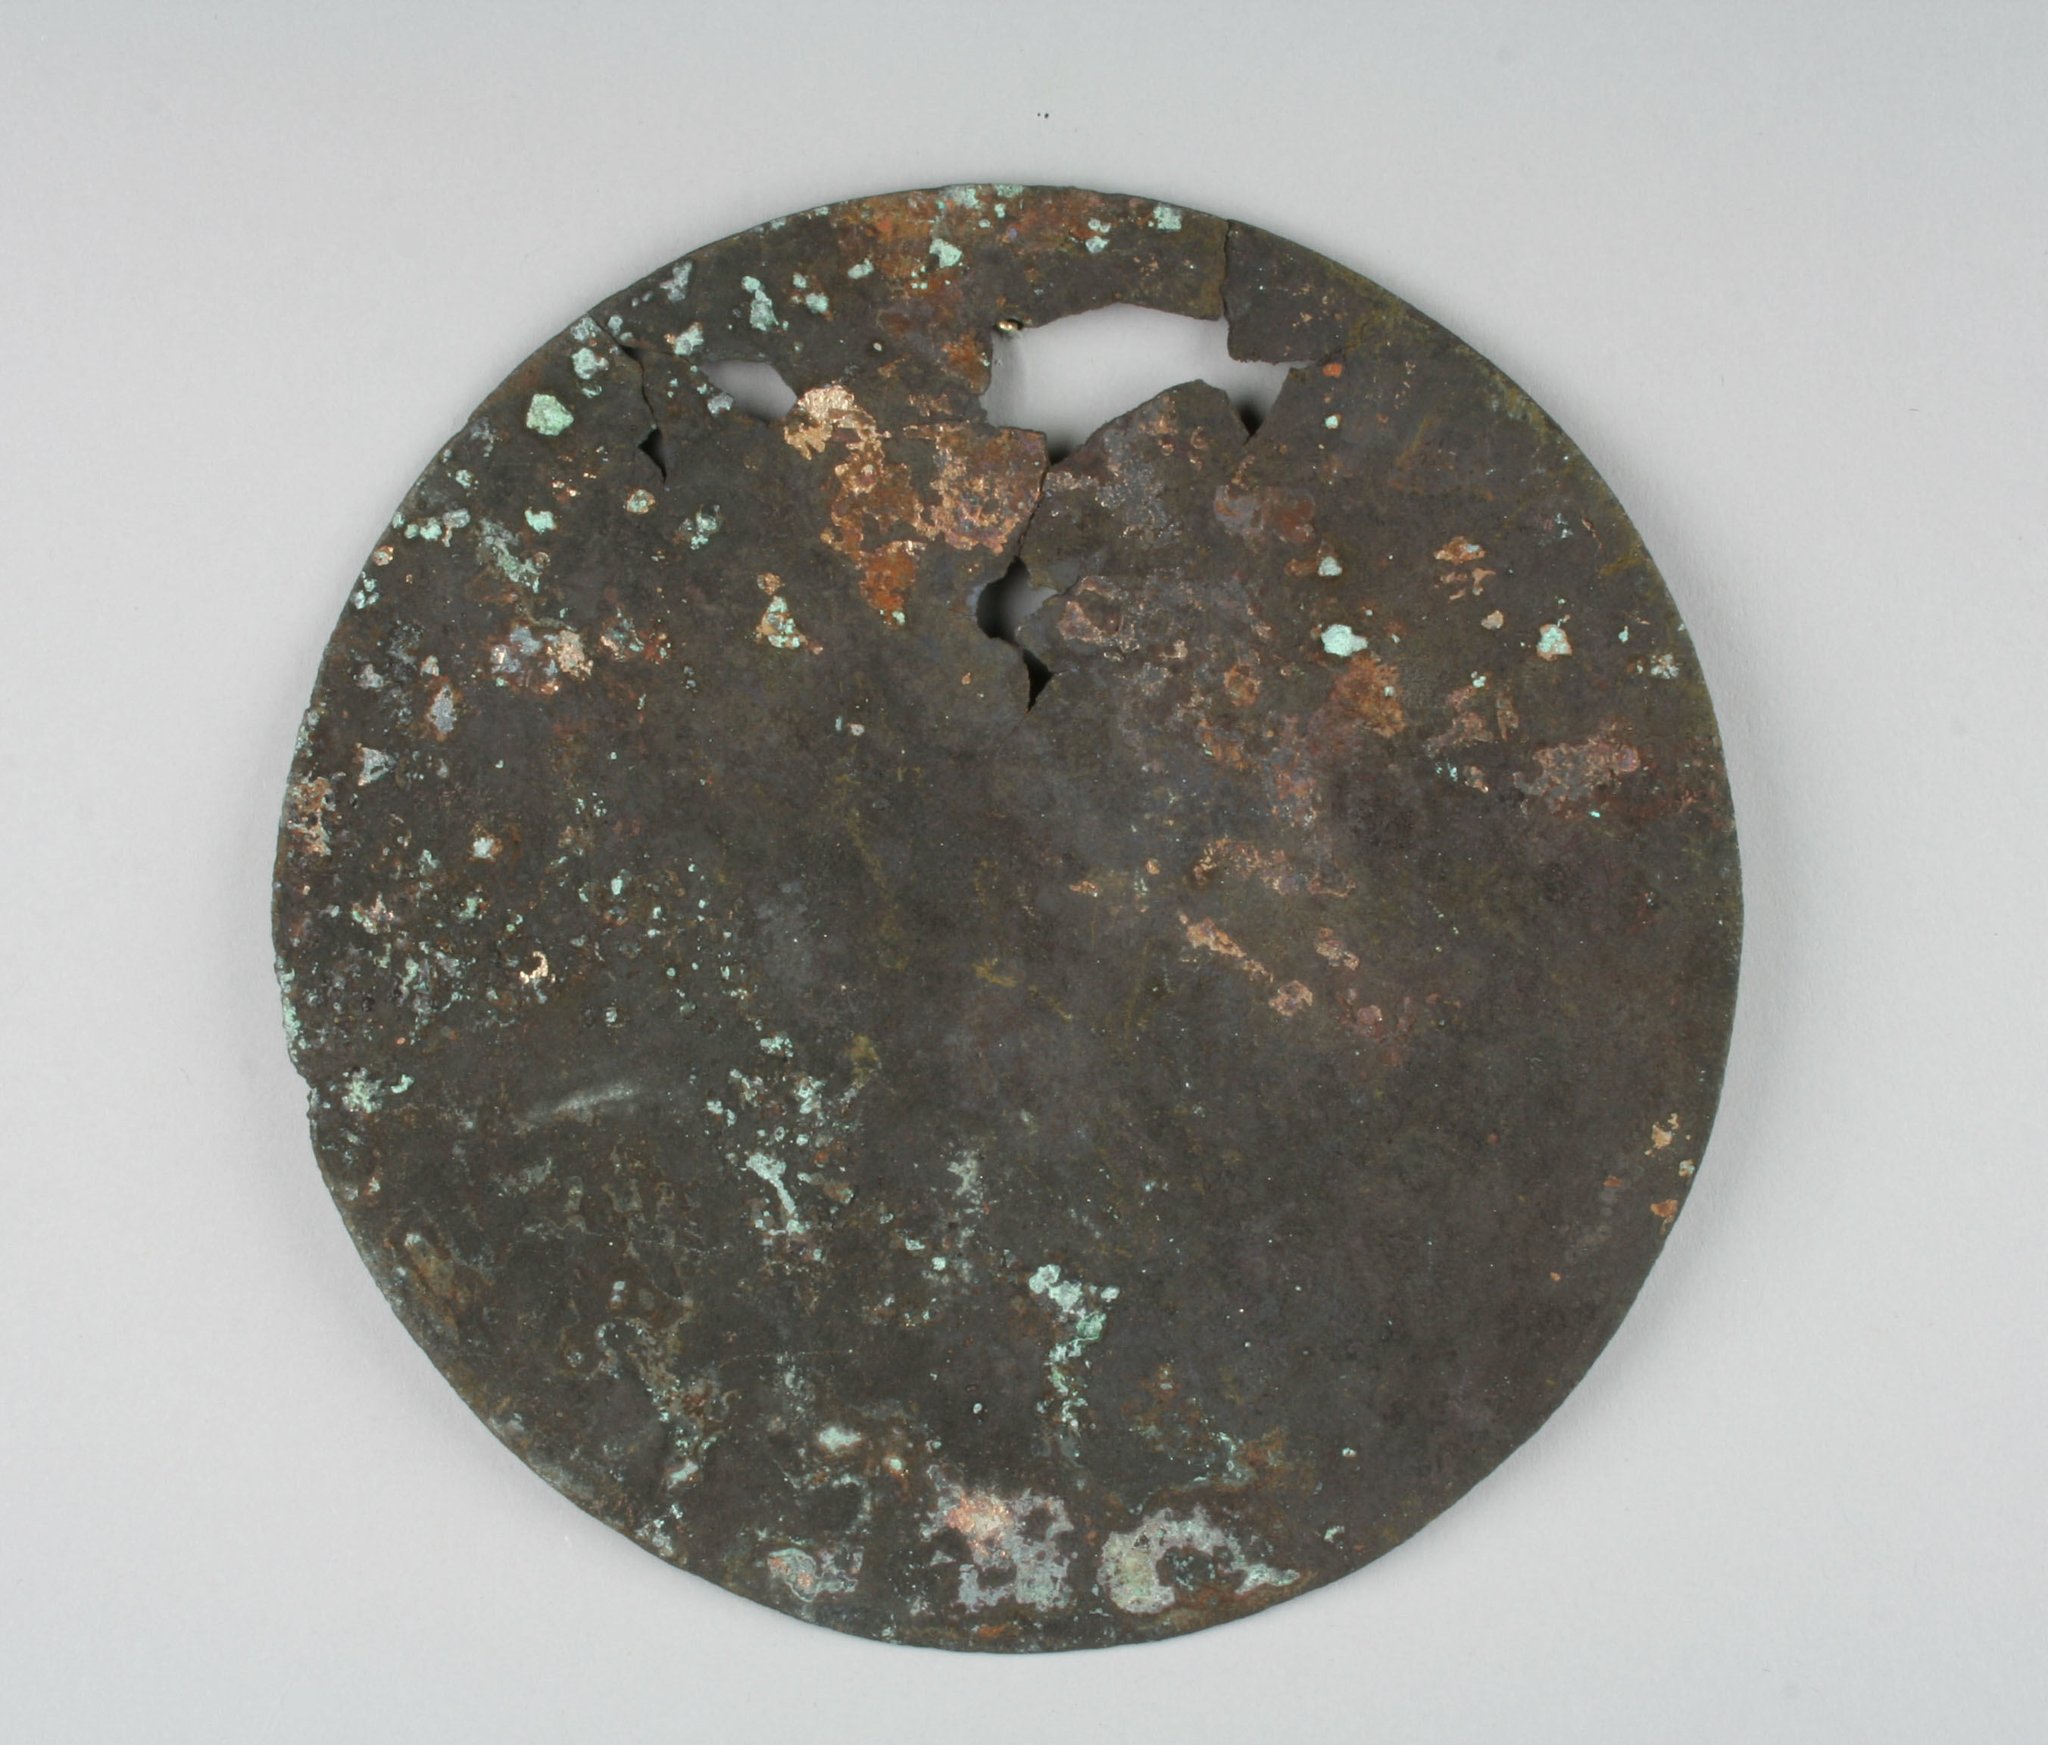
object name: plaque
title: Round Plaque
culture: vicús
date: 300 BCE-200 CE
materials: copper, gilt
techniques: hammering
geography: peru